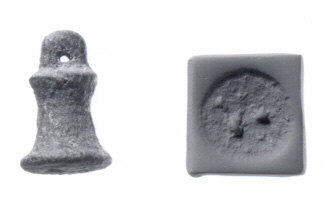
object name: stamp seal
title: Stamp seal (bell-shaped with loop handle) with monster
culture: urartian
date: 800-601 BCE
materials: alloy, bronze, copper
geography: urartu